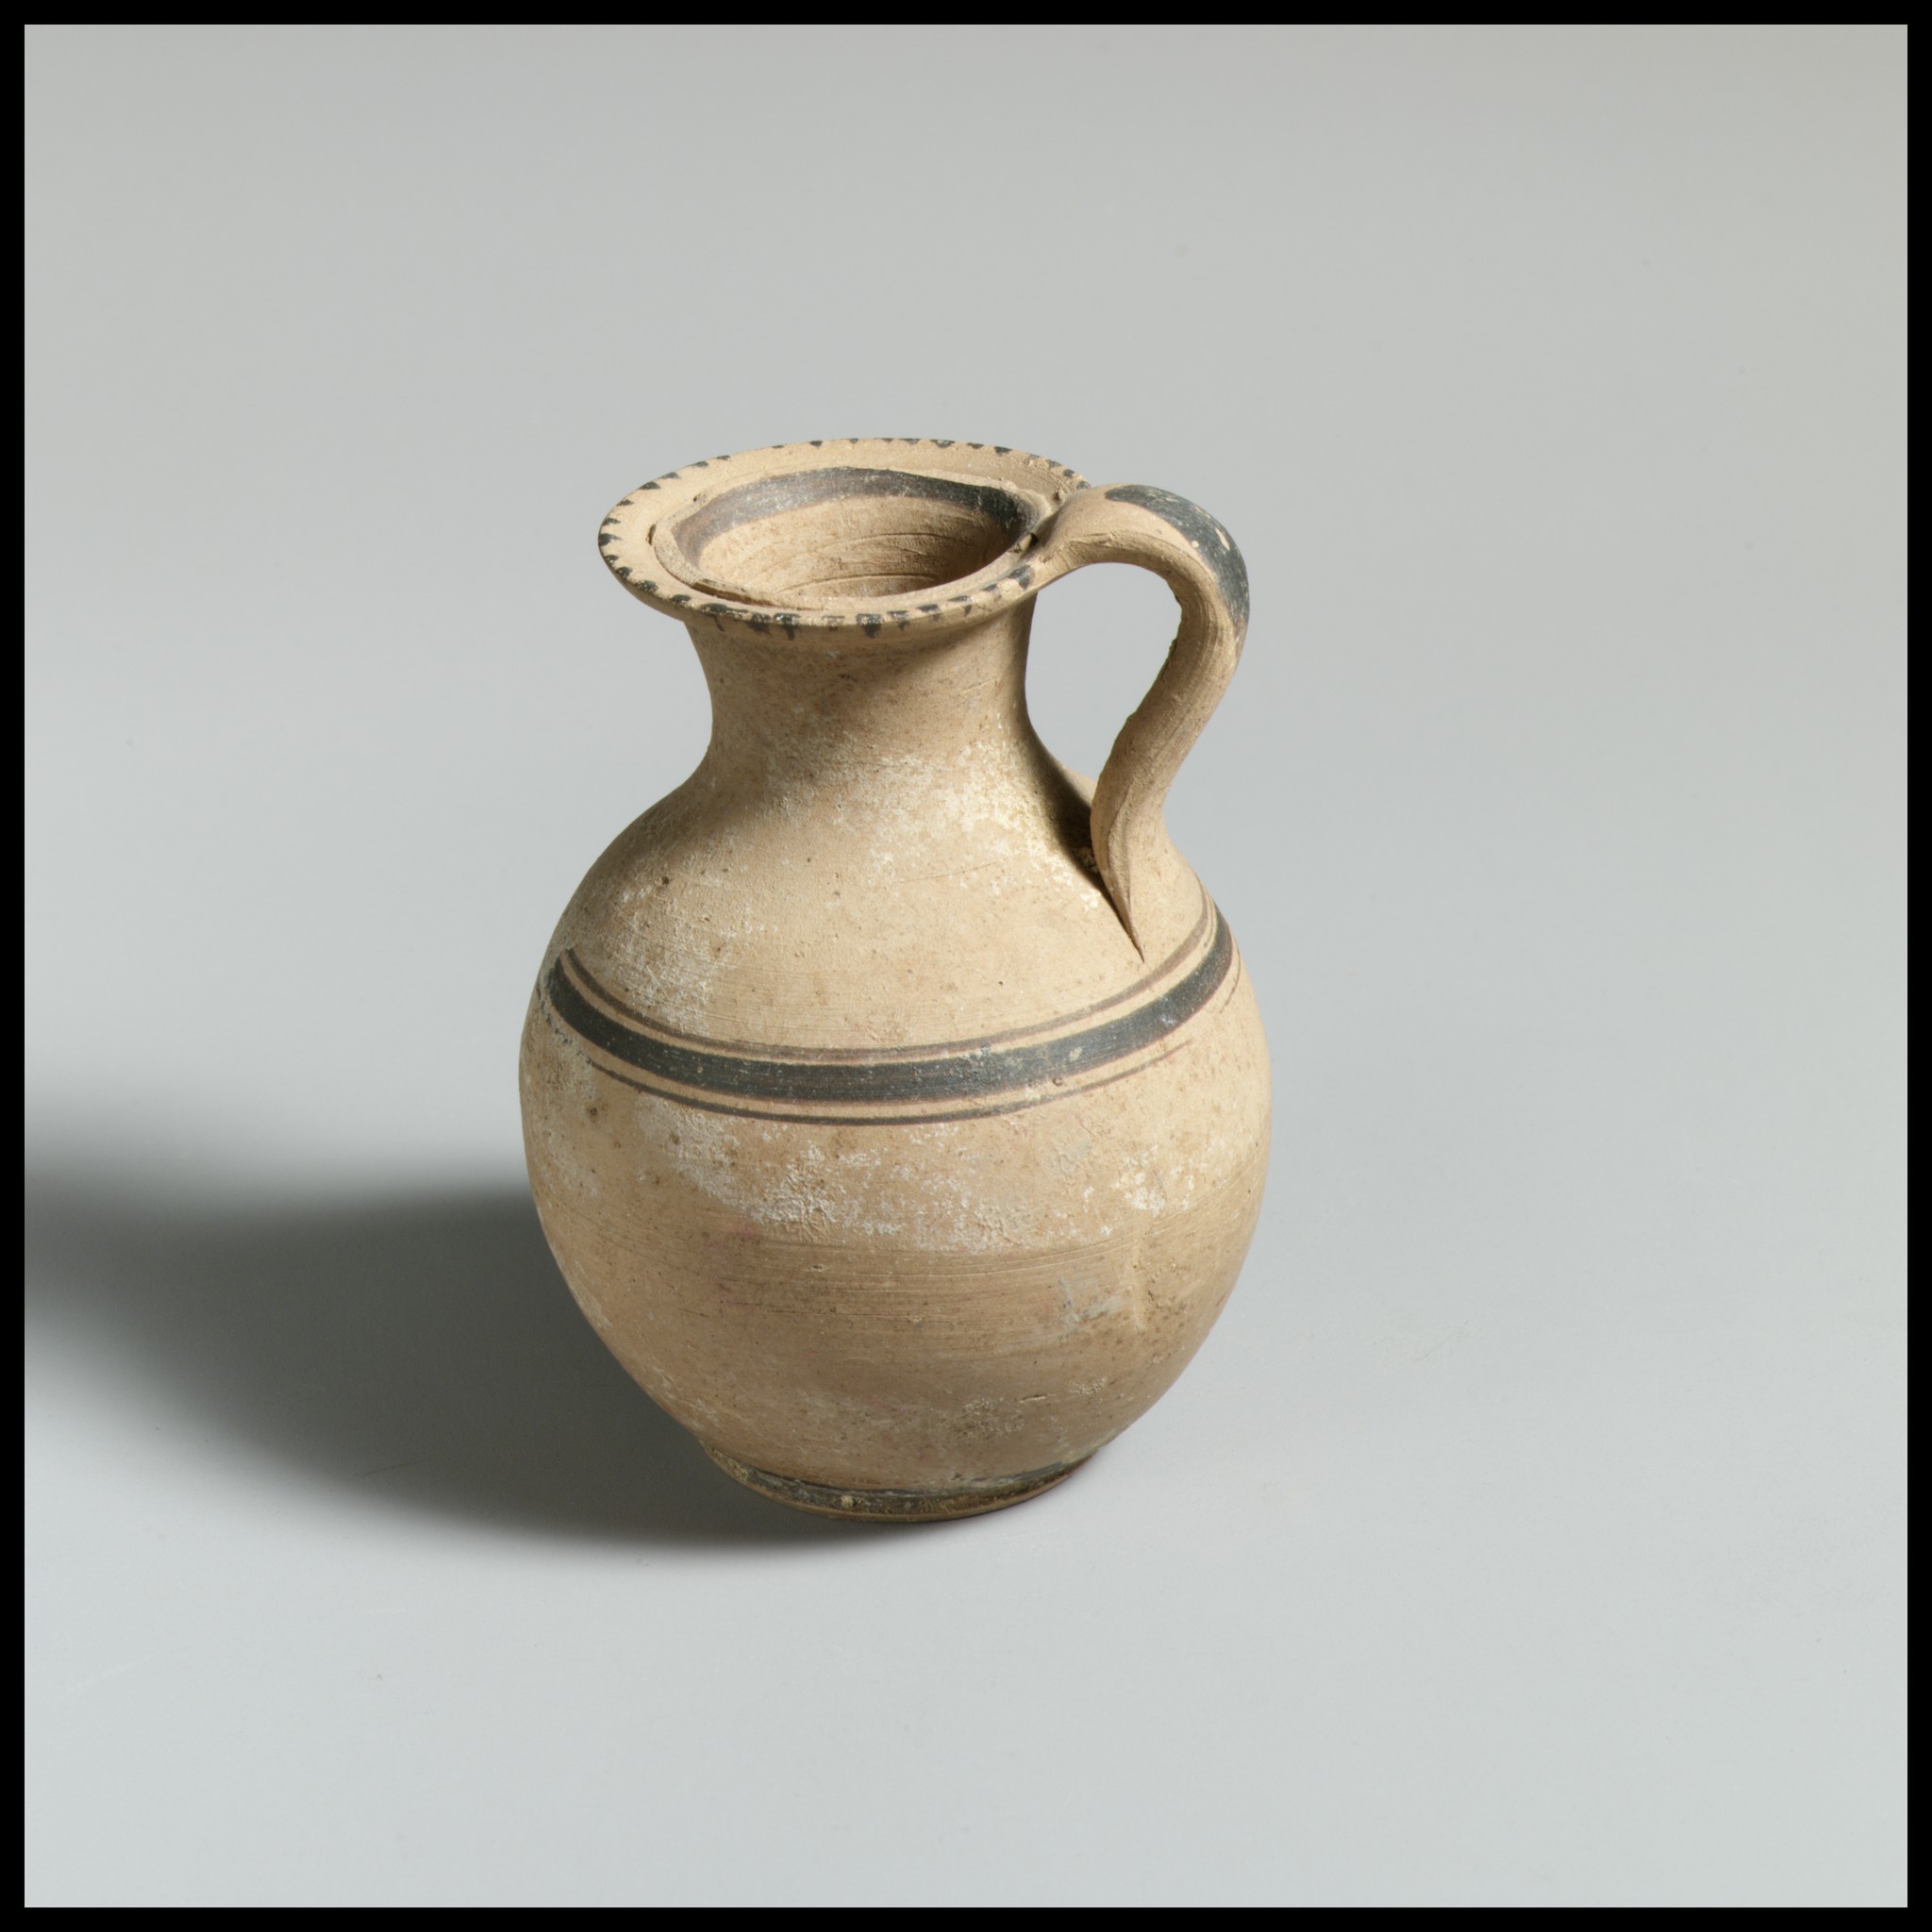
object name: oinochoe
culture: italic, daunian or south italian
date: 900-100 BCE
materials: terracotta